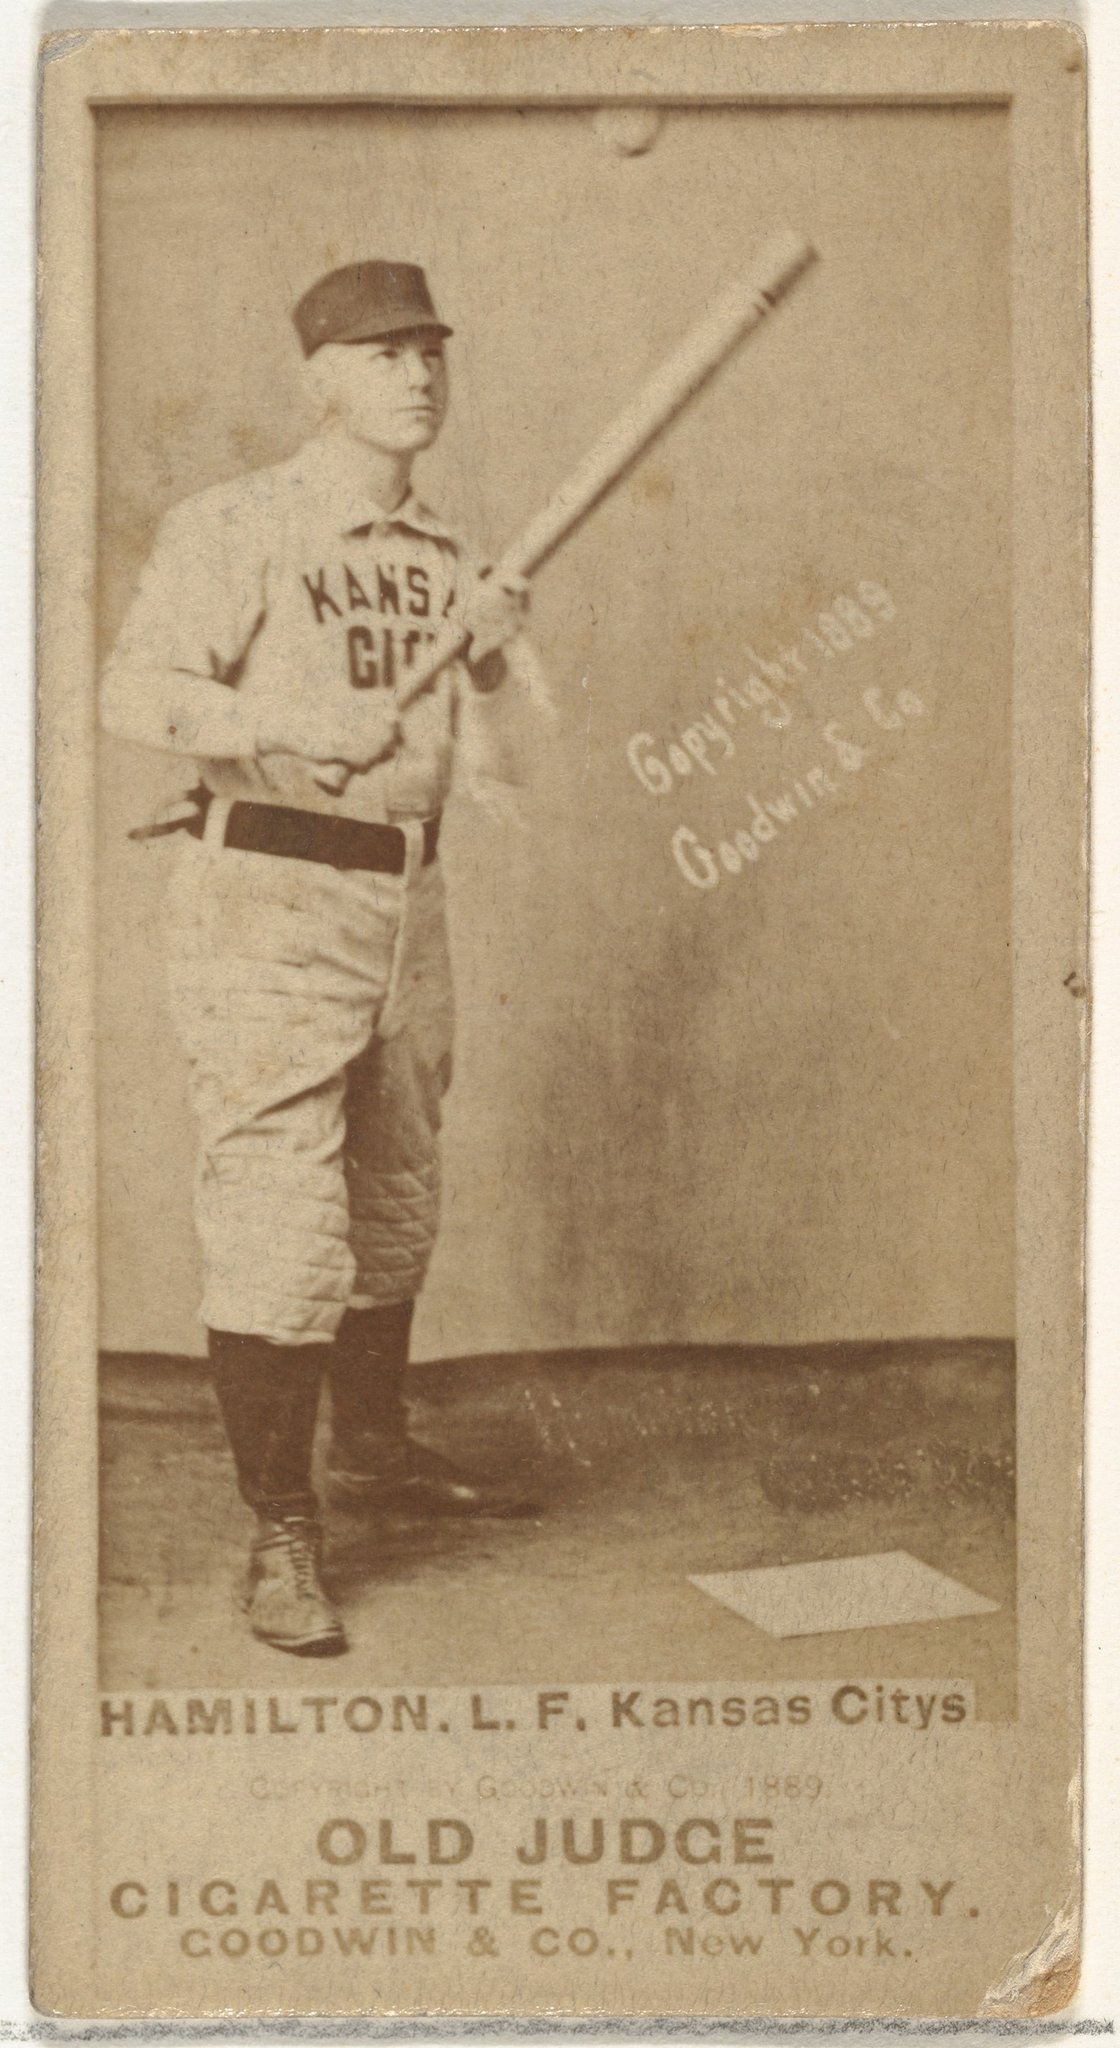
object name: baseball card, photograph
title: William Robert "Sliding Billy" Hamilton, Left Field, Kansas City Cowboys, from the Old Judge series (N172) for Old Judge Cigarettes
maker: goodwin & company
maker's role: publisher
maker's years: 1850-1950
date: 1889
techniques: albumen silver print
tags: men,portraits,baseball,athletes